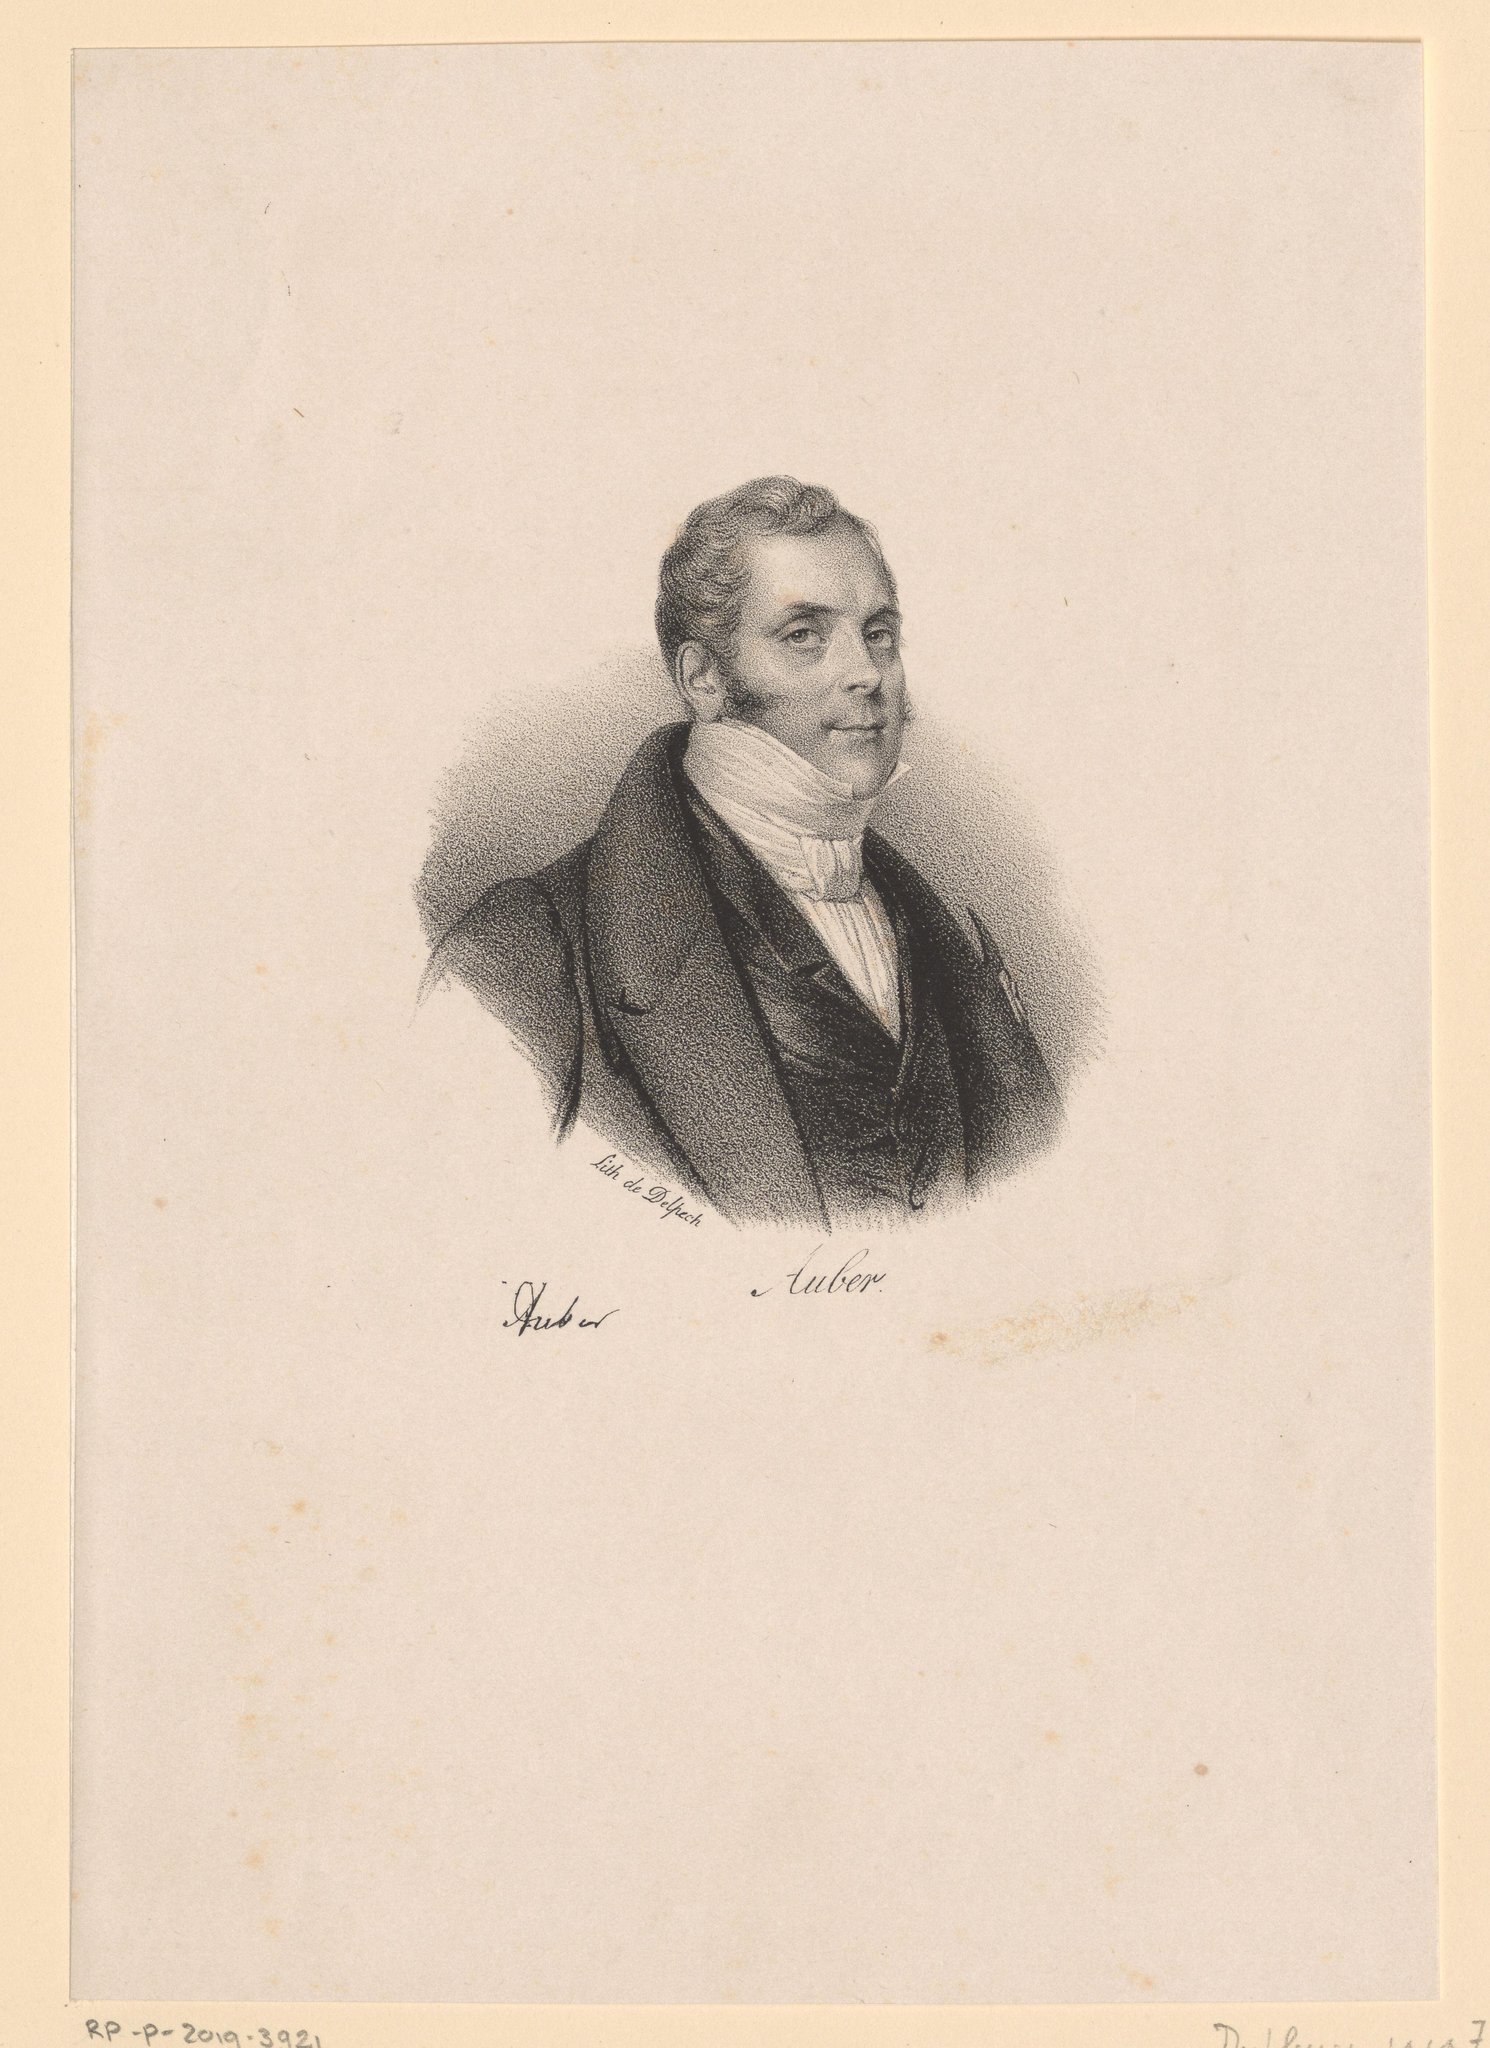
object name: print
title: Portret van Daniel-François-Esprit Auber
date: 1818-1825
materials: paper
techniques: lithograph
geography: paris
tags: historical persons